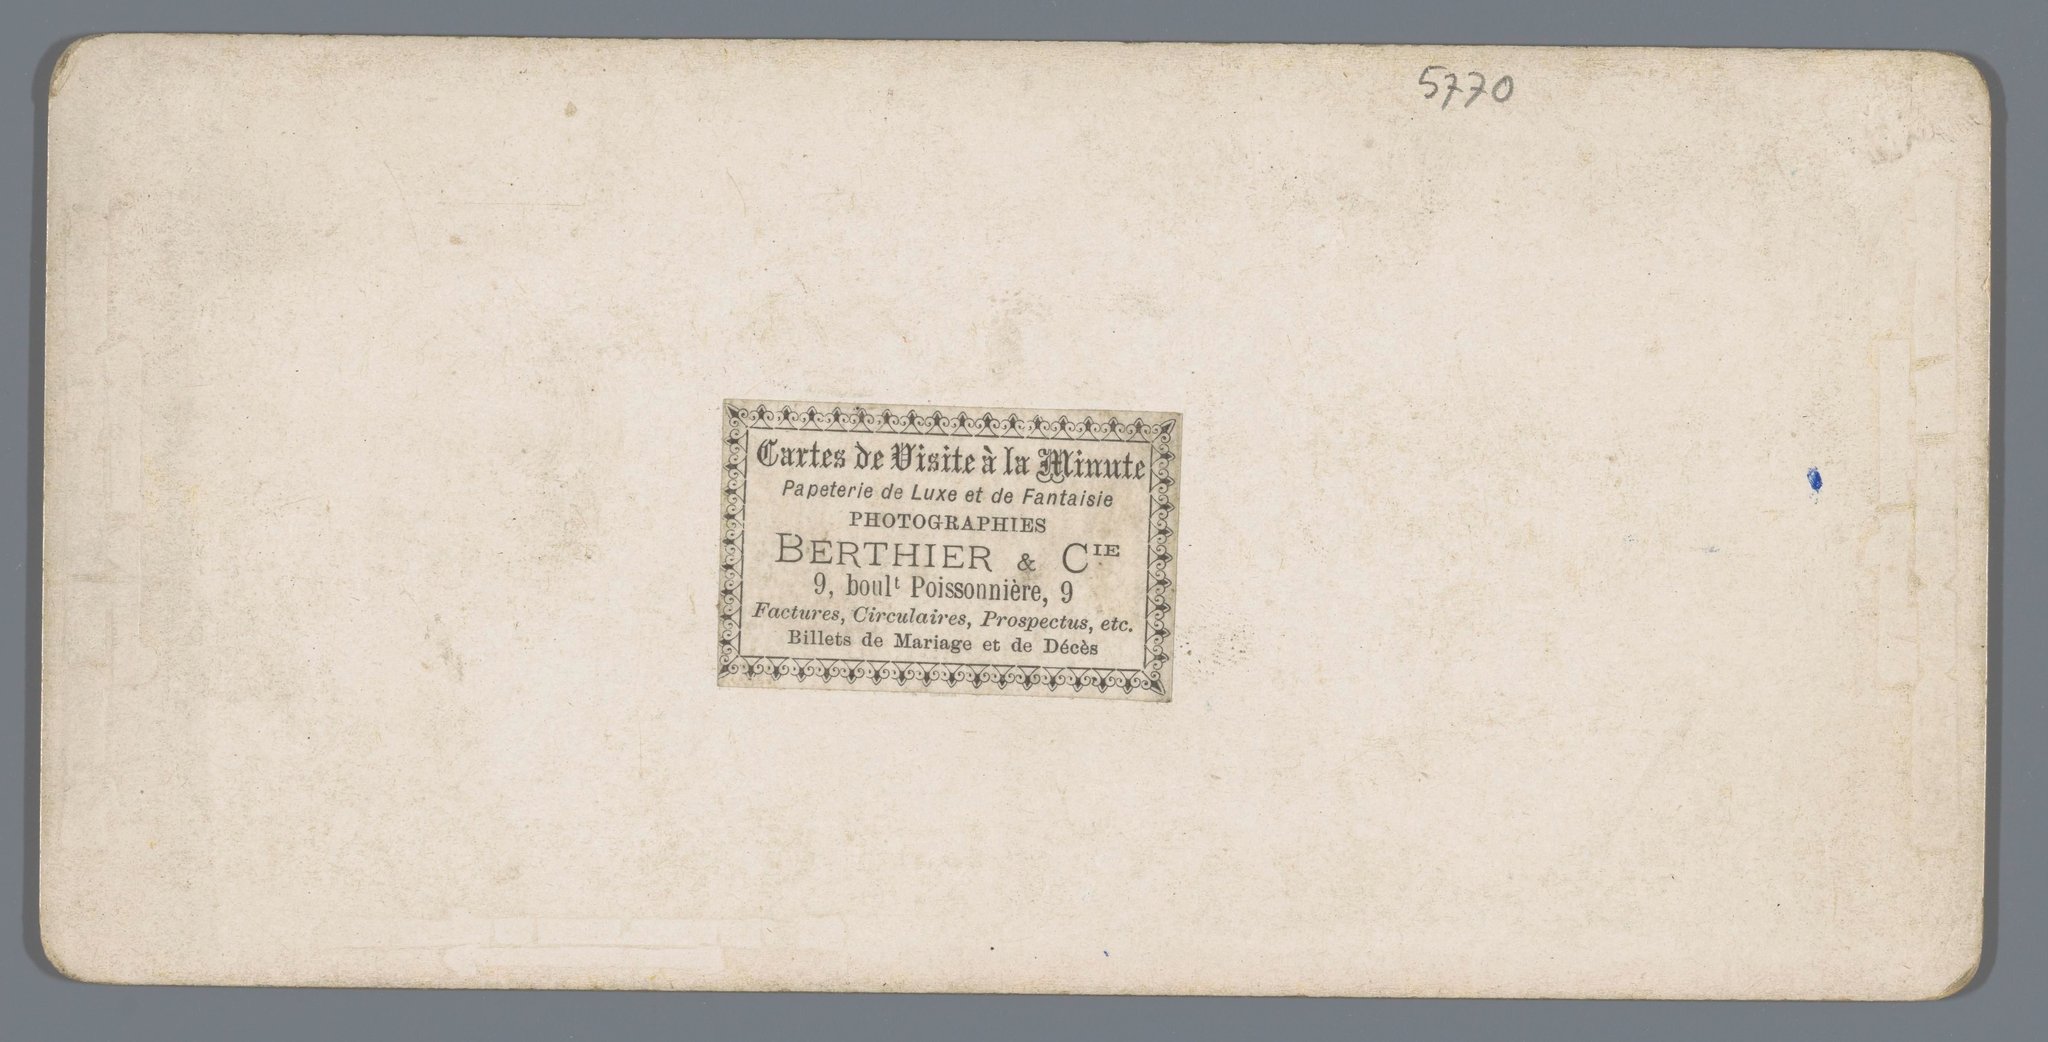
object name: stereograph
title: Le Pouff, Salon de Réception, (Hotel-de-Ville de Paris)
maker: ernest eléonor pierre lamy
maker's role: publisher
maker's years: 1828-1900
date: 1860-1880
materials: cardboard, photographic support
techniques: albumen print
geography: paris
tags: townhall, interior ~ representation of a building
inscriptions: name: ‘Cartes de Visite à la Minute Papeterie de Luxe et de Fantaisie Photographies Berthier & Cie 9, boult Poissonnière, 9 Factures, Circulaires, Prospectus, etc. Billets de Mariage et de Décès’, number: ‘5’, inscription: ‘E. Lamy's collection’